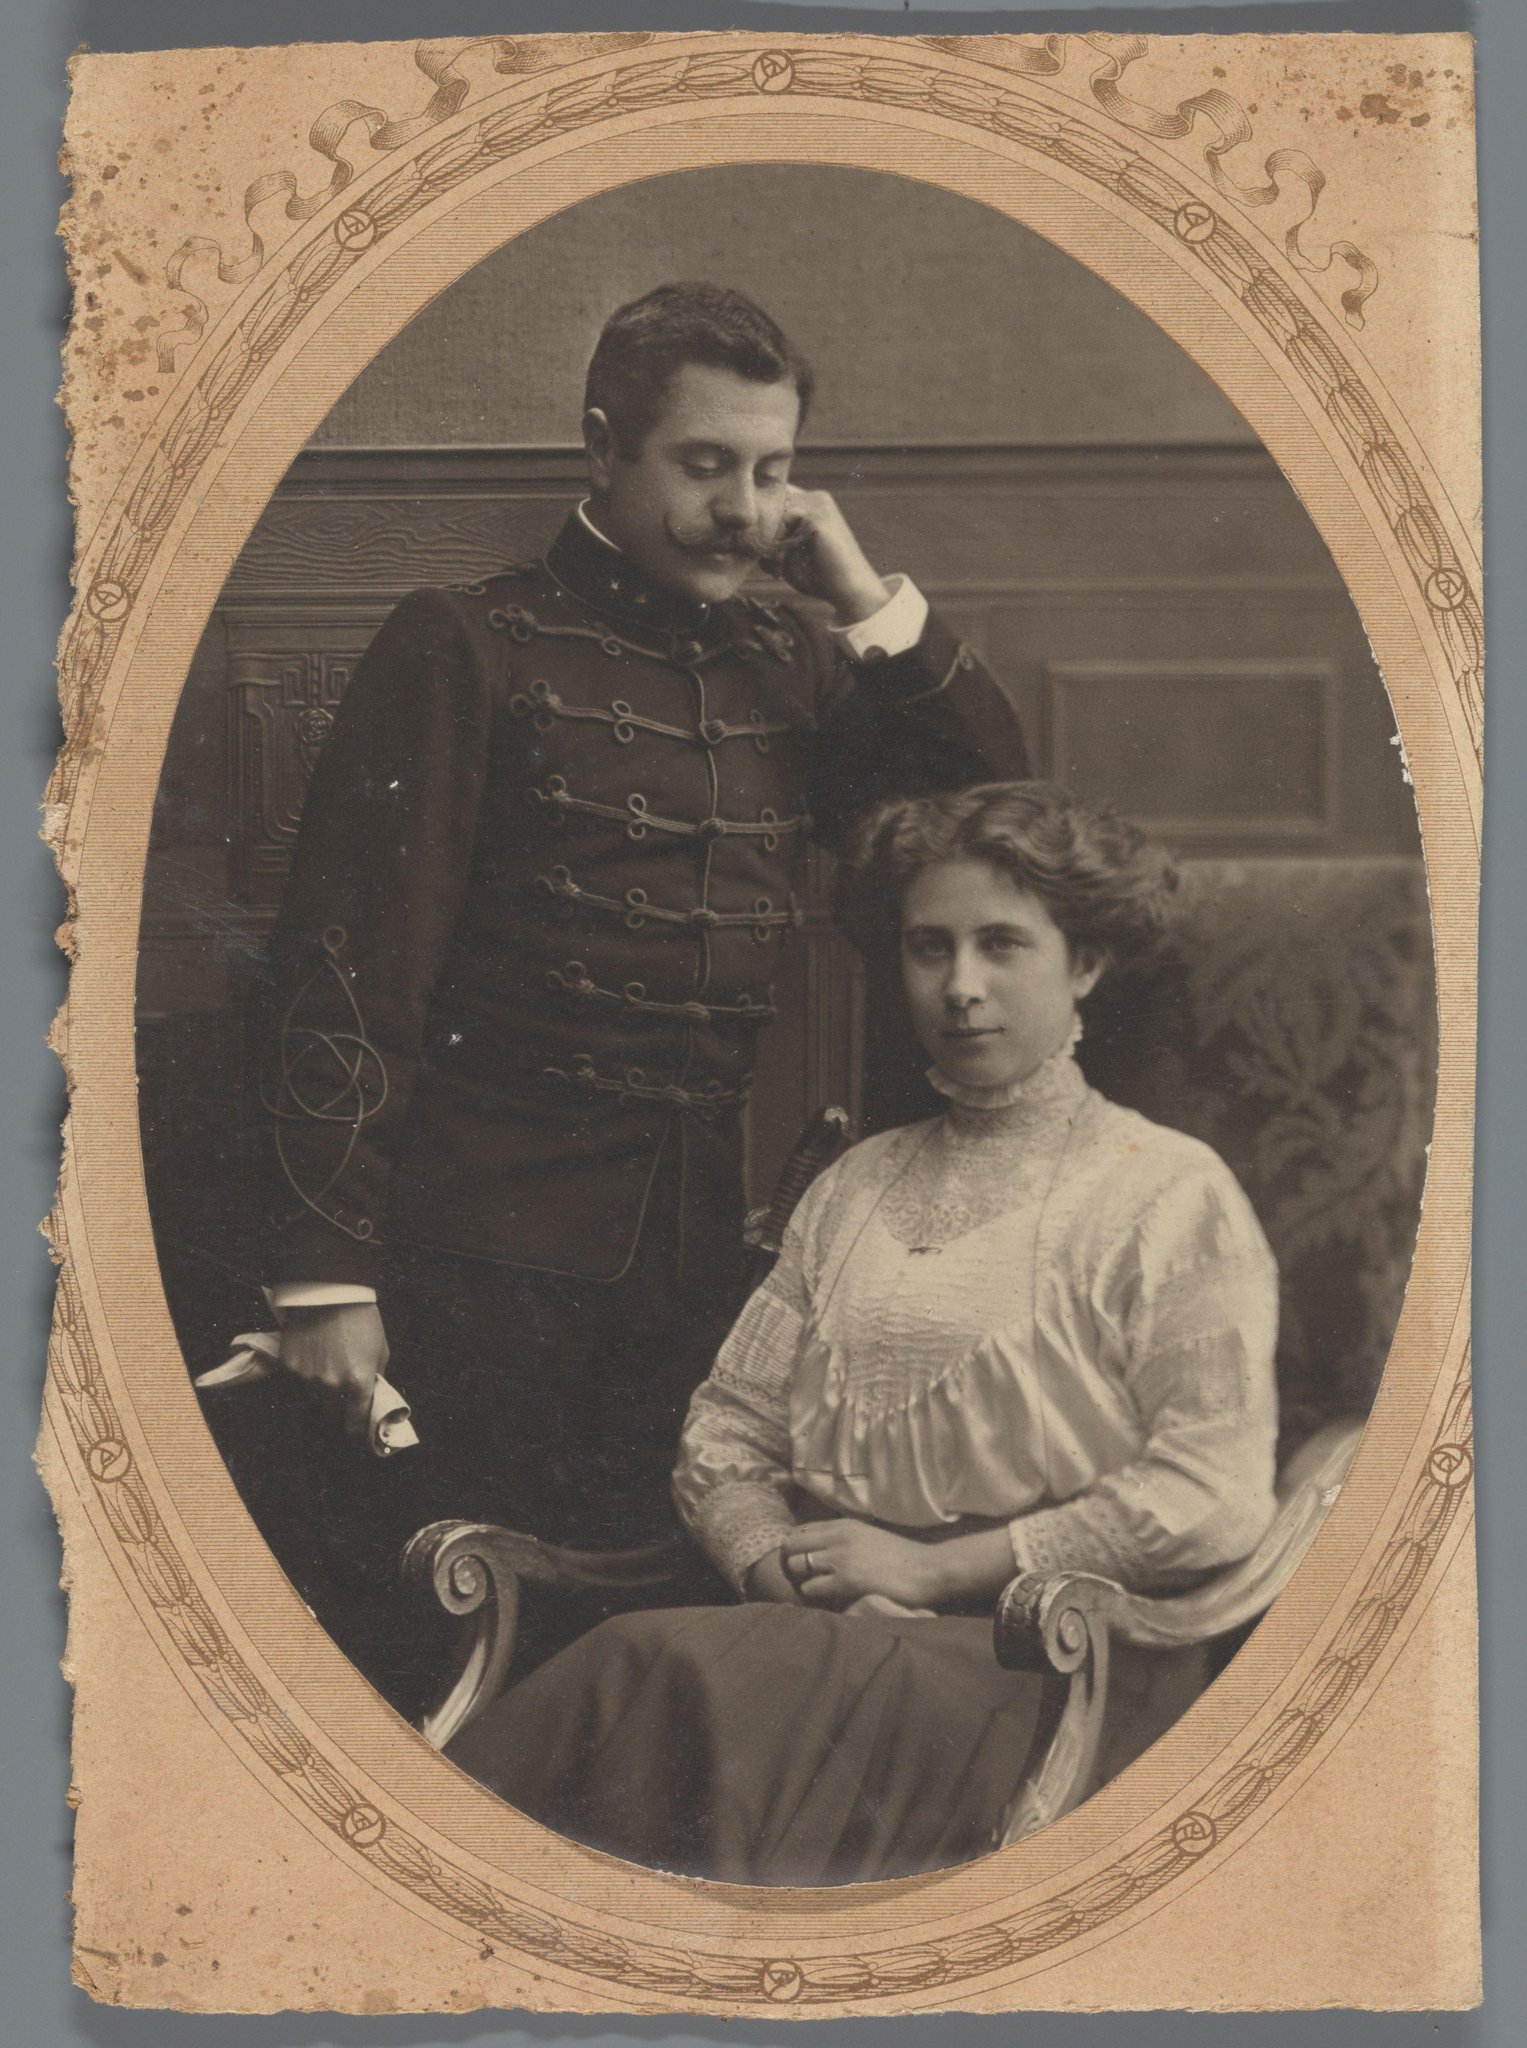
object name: photograph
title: Portret van een onbekende man in legeruniform en een onbekende vrouw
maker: Anonymous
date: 1885-1910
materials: paper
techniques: gelatin silver print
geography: netherlands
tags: historical persons not known by name - bb - woman, (military) uniforms, historical persons not known by name, netherlands